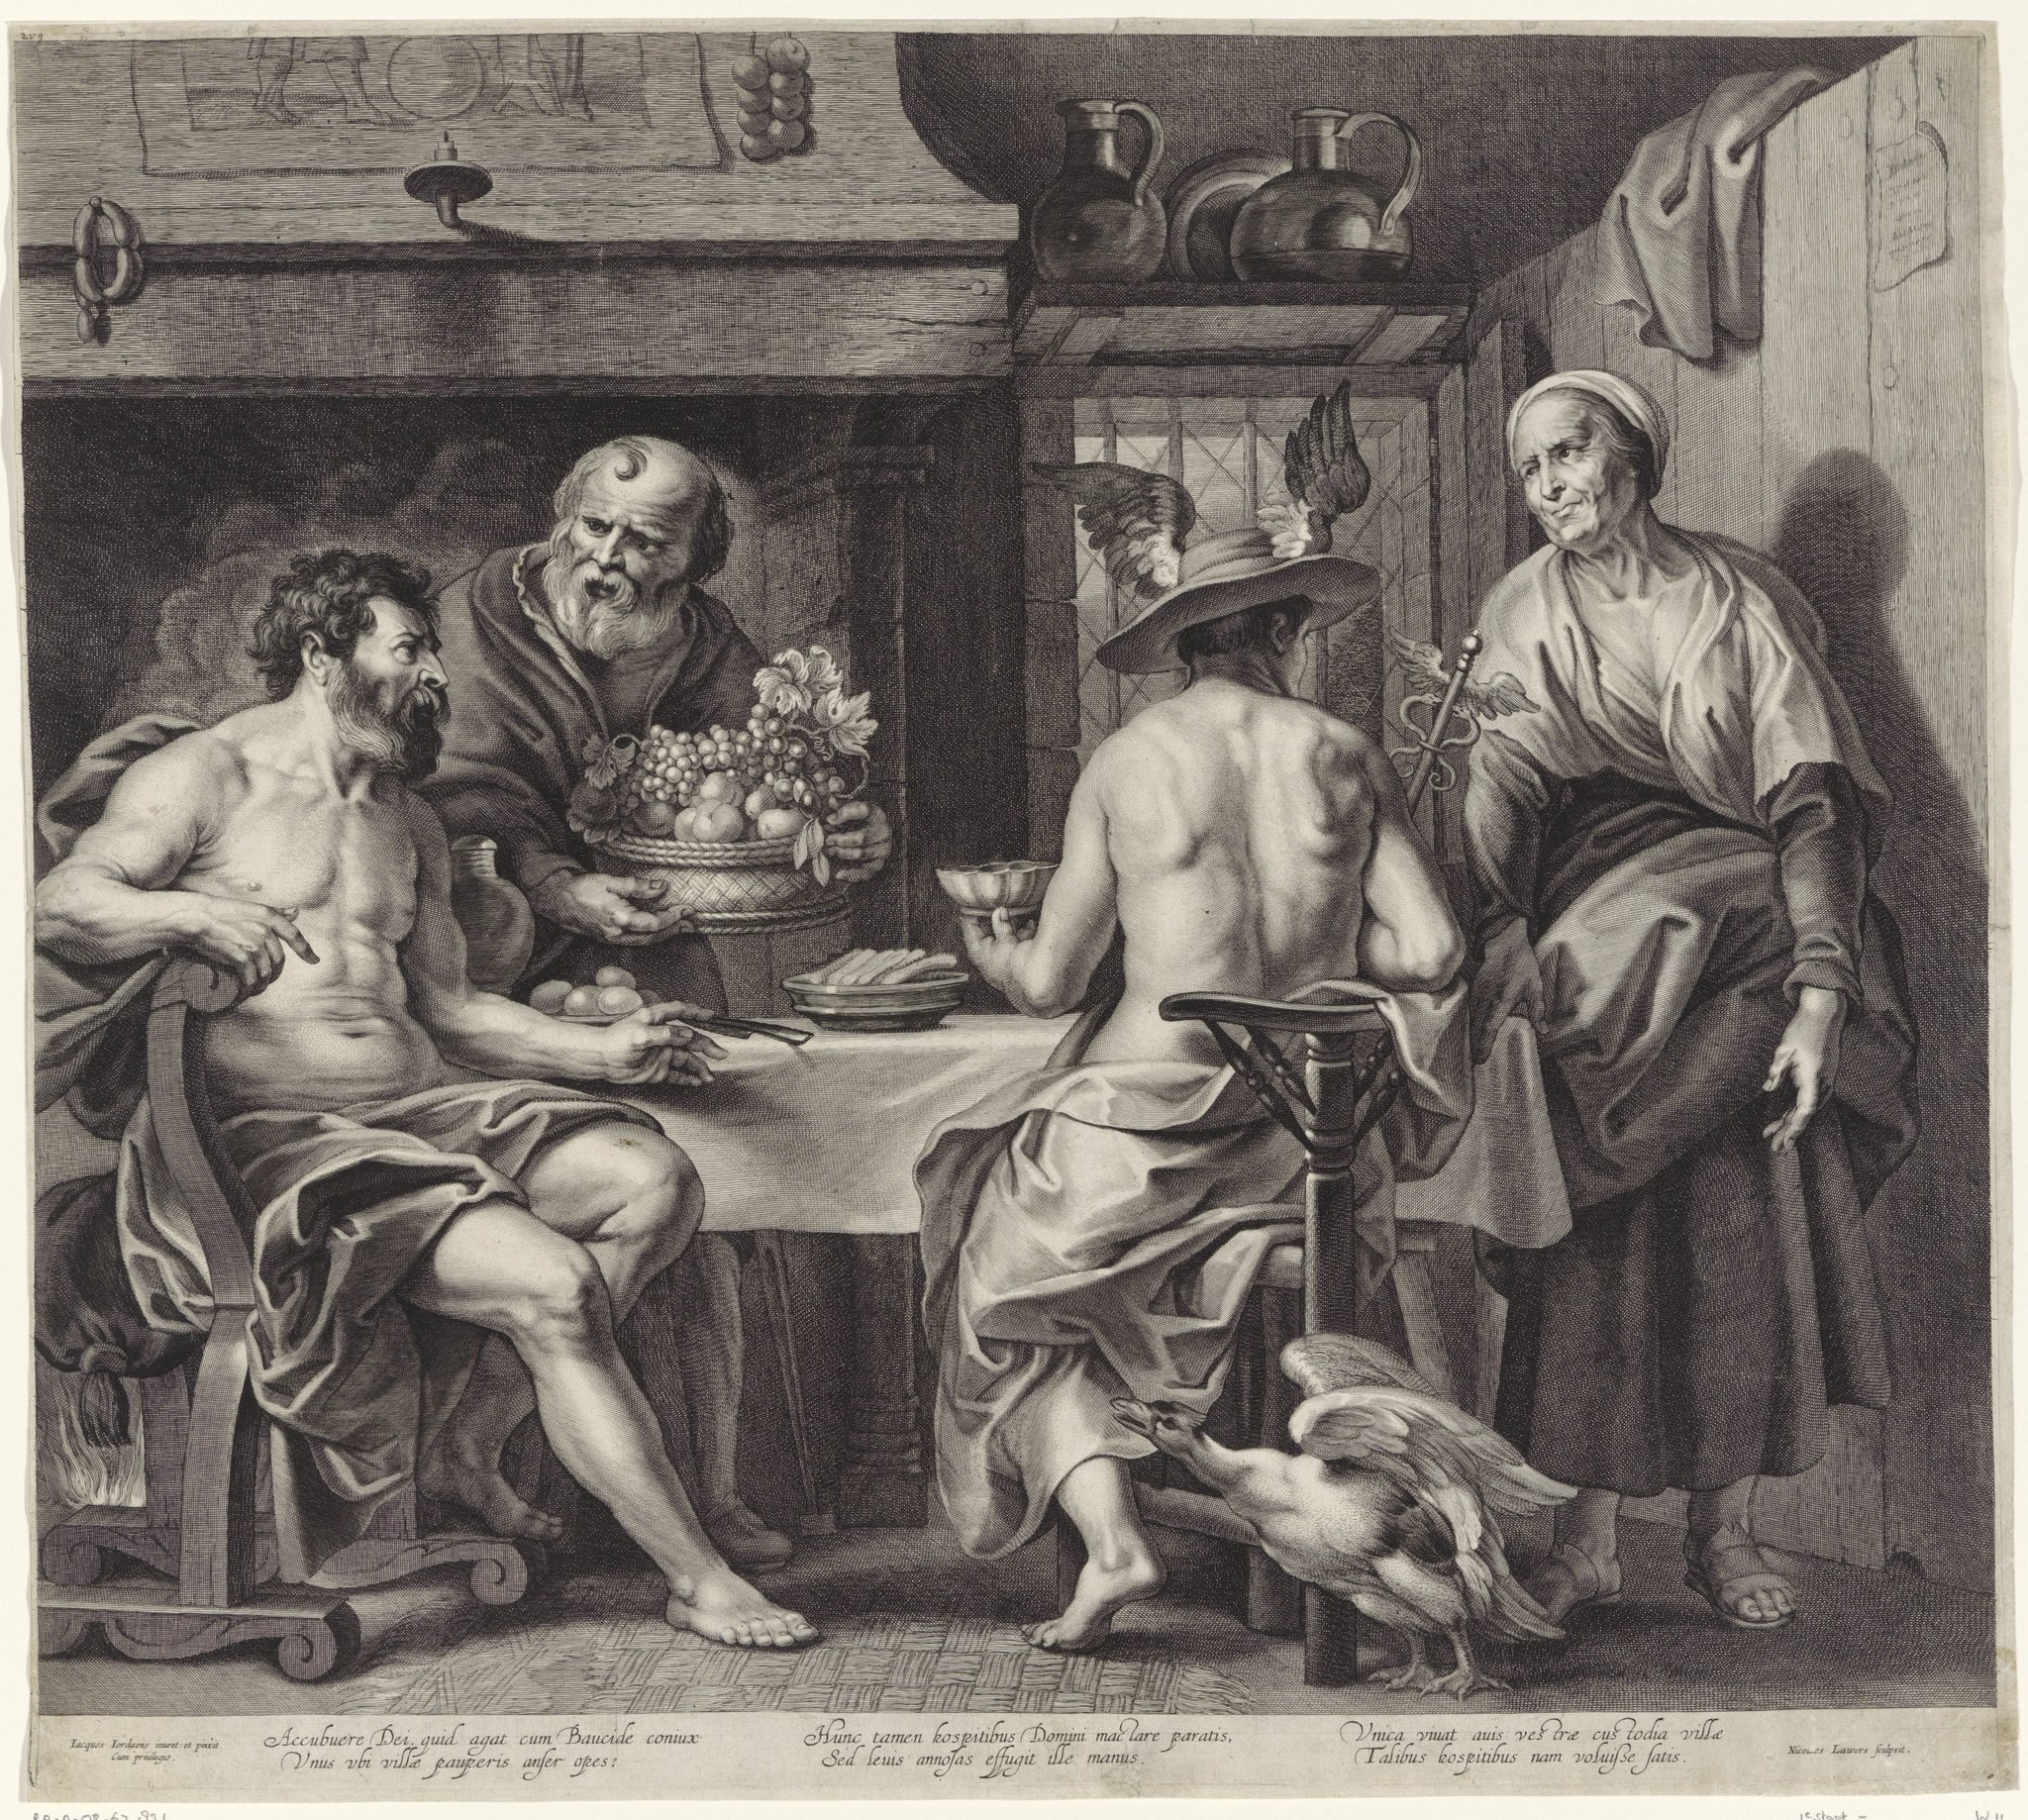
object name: print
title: Jupiter en Mercurius in het huis van Philemon en Baucis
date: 1619-1652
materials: paper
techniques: engraving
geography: antwerp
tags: philemon and his wife baucis hospitably entertain jupiter and mercury in travellers' guise; possibly a goose, which they try to kill for the occasion, flies to the visitors for refuge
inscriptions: number: ‘209’, collector's mark: Lugt 240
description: Jupiter en Mercurius, in de gedaante van reizigers, bezoeken Philemon en Baucis, die hen gastvrijheid bieden. Philemon biedt Jupiter fruit aan terwijl Baucis probeert een vluchtende gans te pakken.